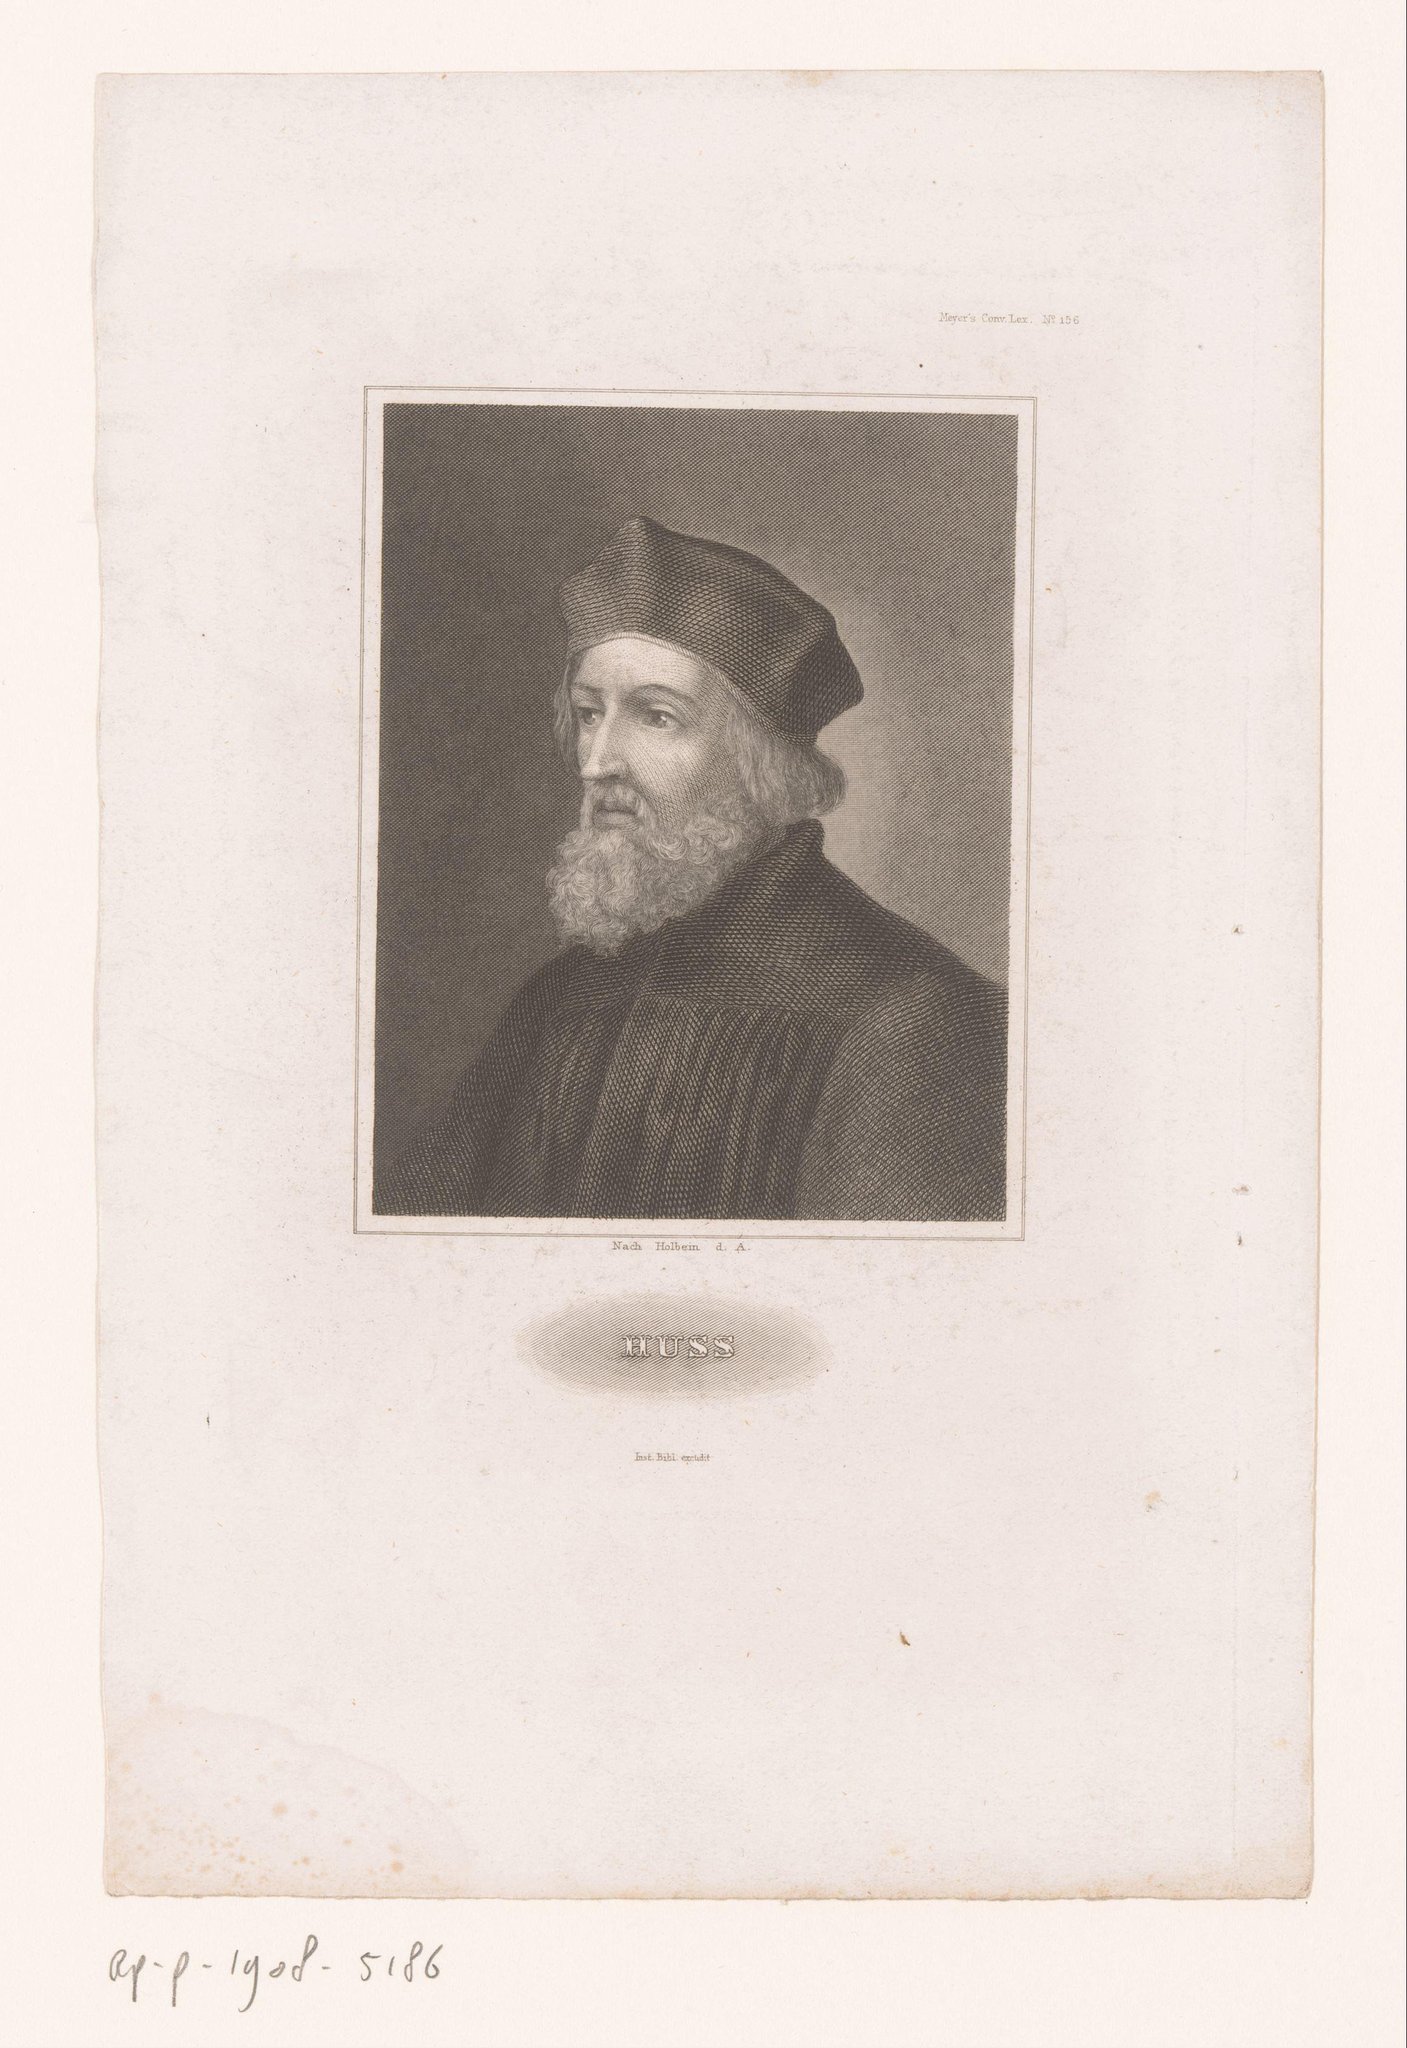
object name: print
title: Portret van Johannes Hus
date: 1800-1899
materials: paper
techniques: engraving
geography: germany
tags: historical persons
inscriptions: collector's mark: Lugt 2228